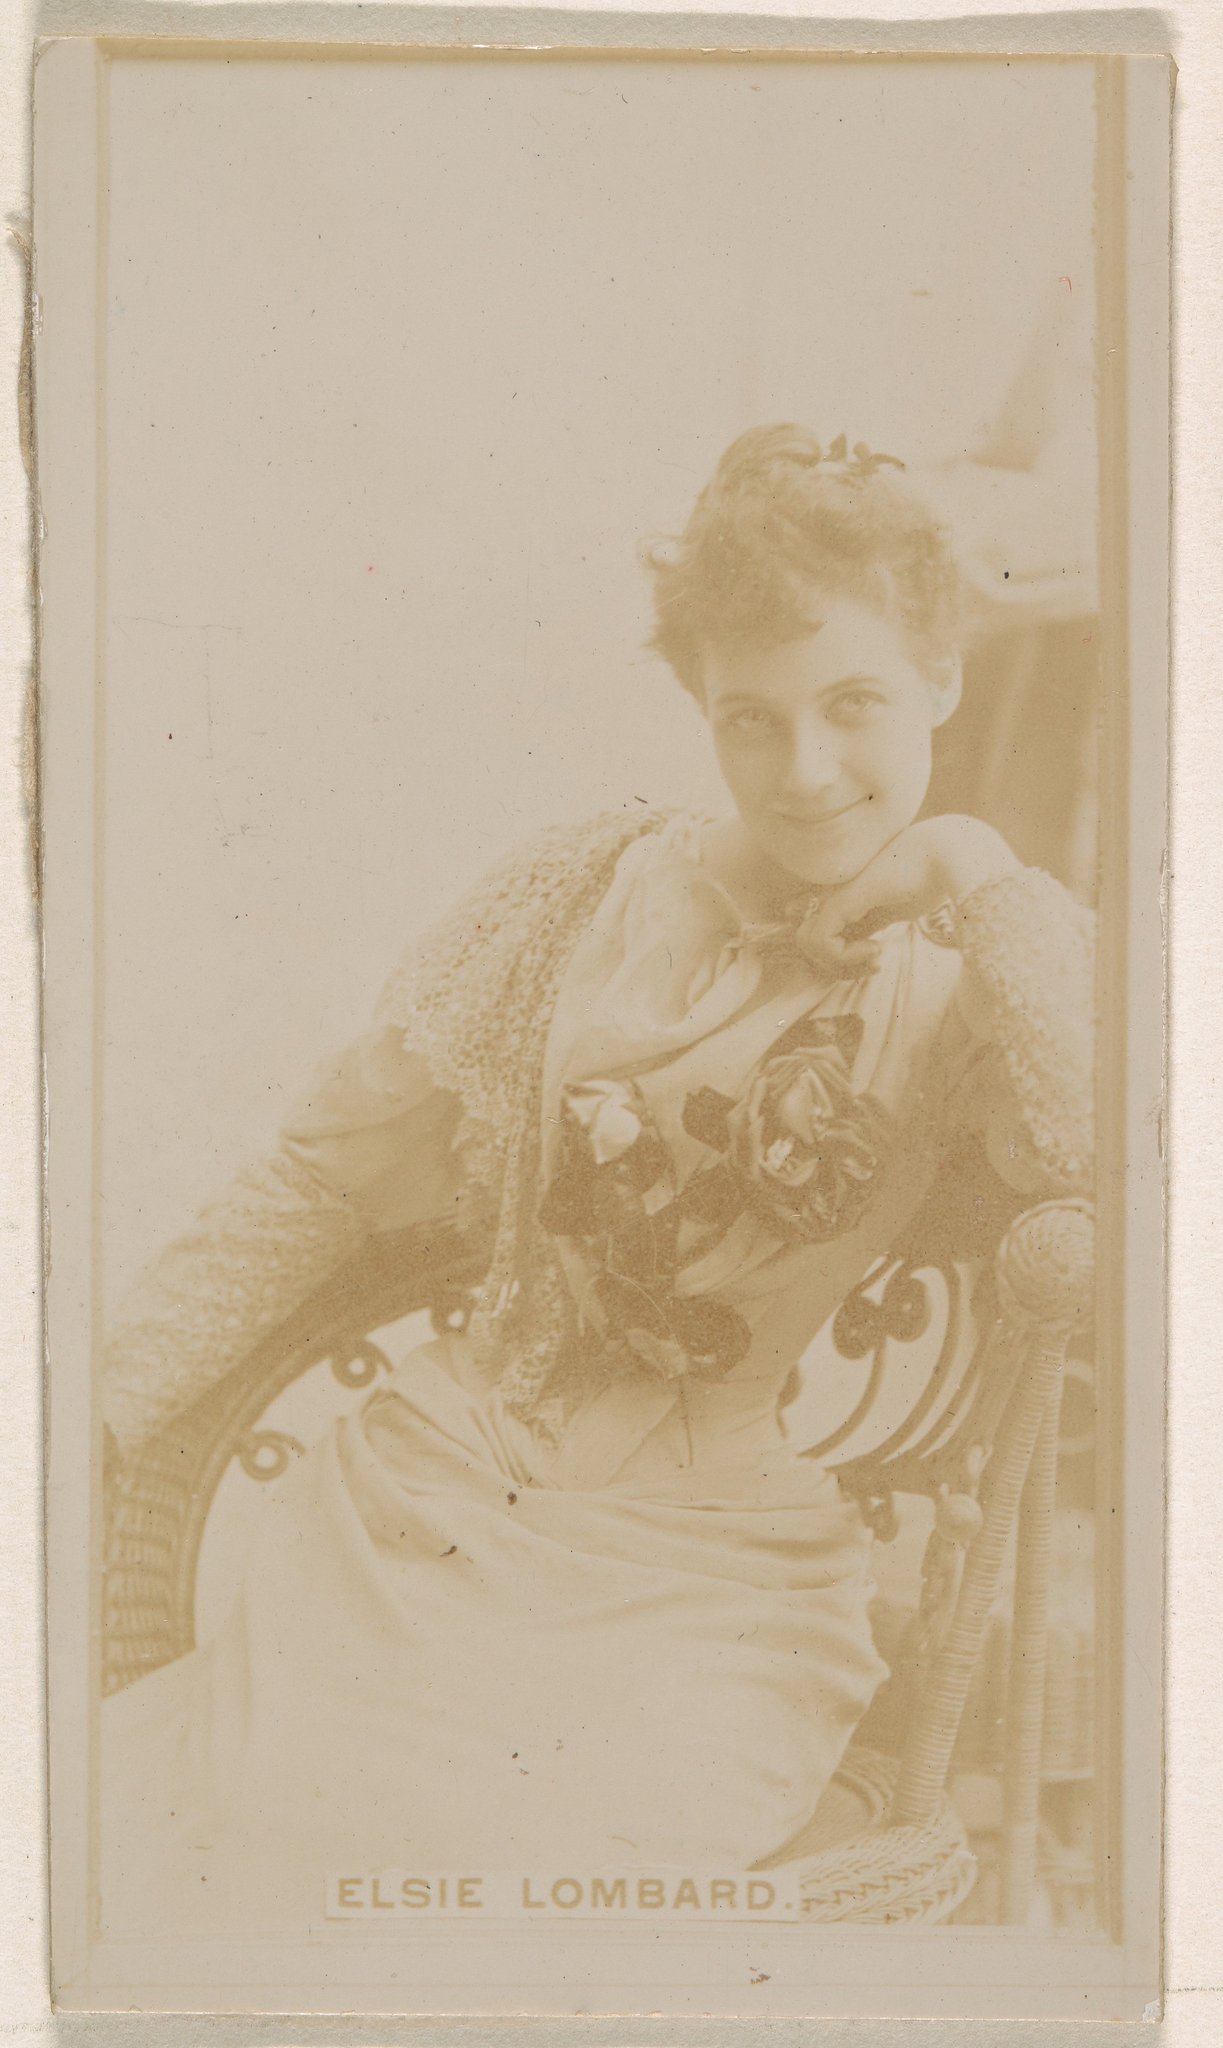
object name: photograph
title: Elsie Lombard, from the Actresses series (N245) issued by Kinney Brothers to promote Sweet Caporal Cigarettes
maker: kinney brothers tobacco company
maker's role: publisher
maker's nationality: american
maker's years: 1869-2011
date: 1890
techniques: albumen silver print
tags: portraits,women,actresses